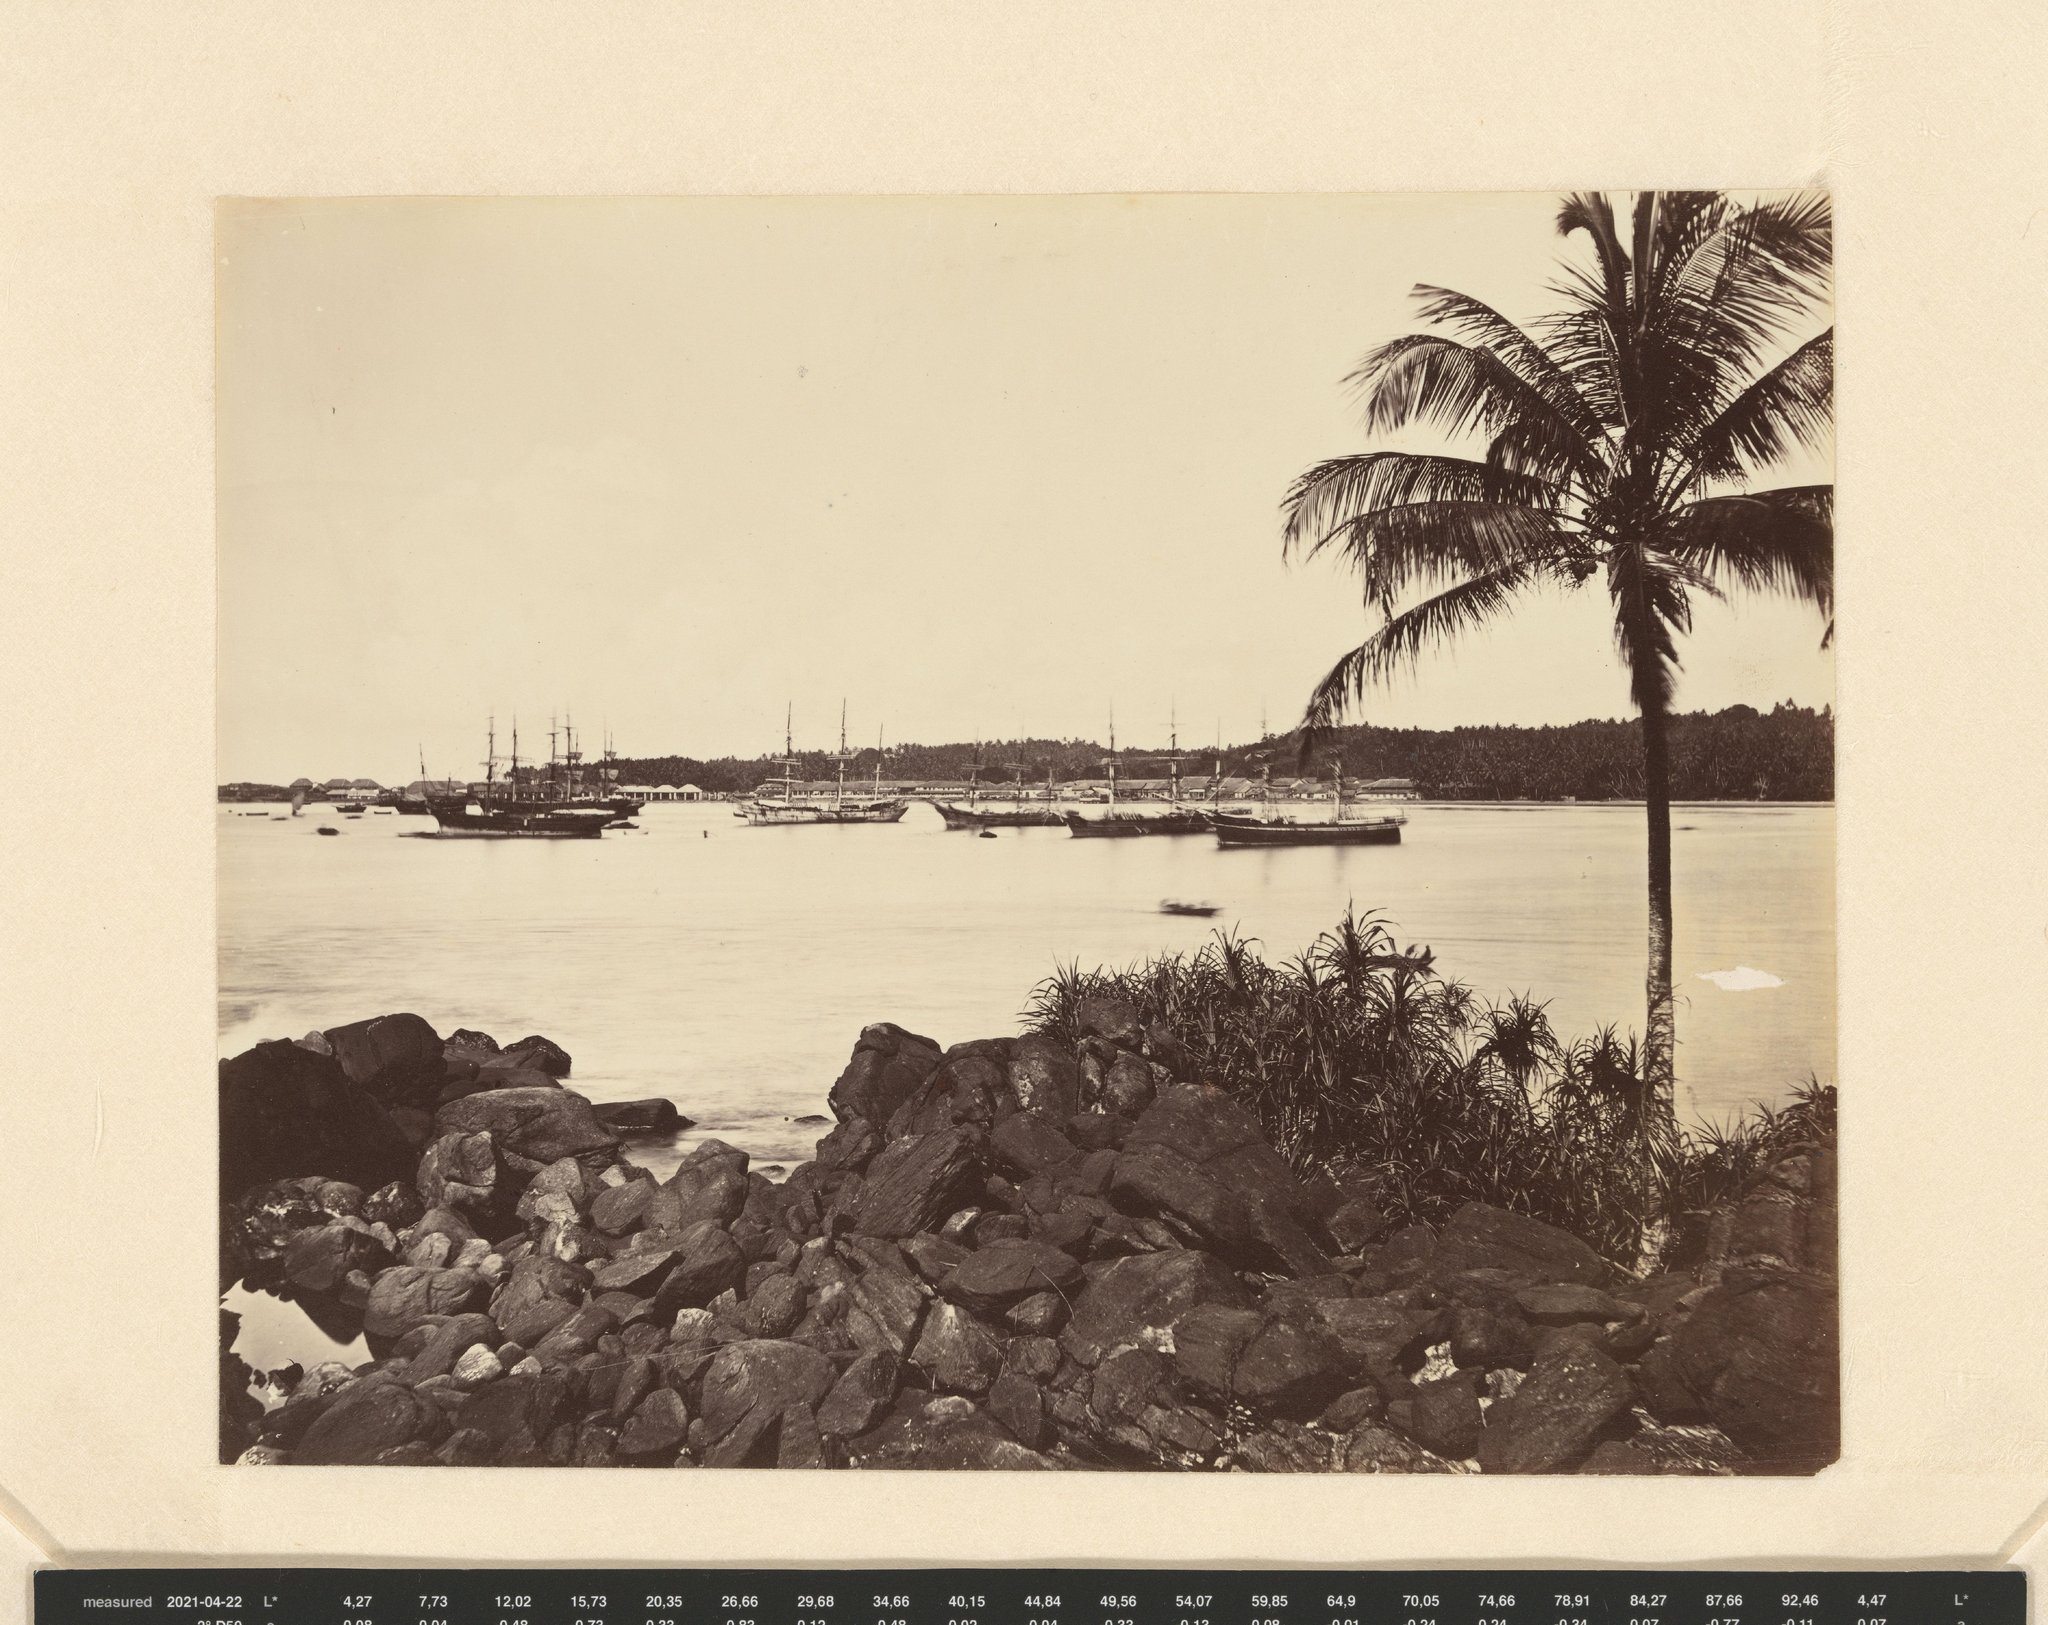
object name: photograph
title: Haven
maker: Anonymous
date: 1865-1870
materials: paper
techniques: albumen print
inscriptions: number: ‘18’